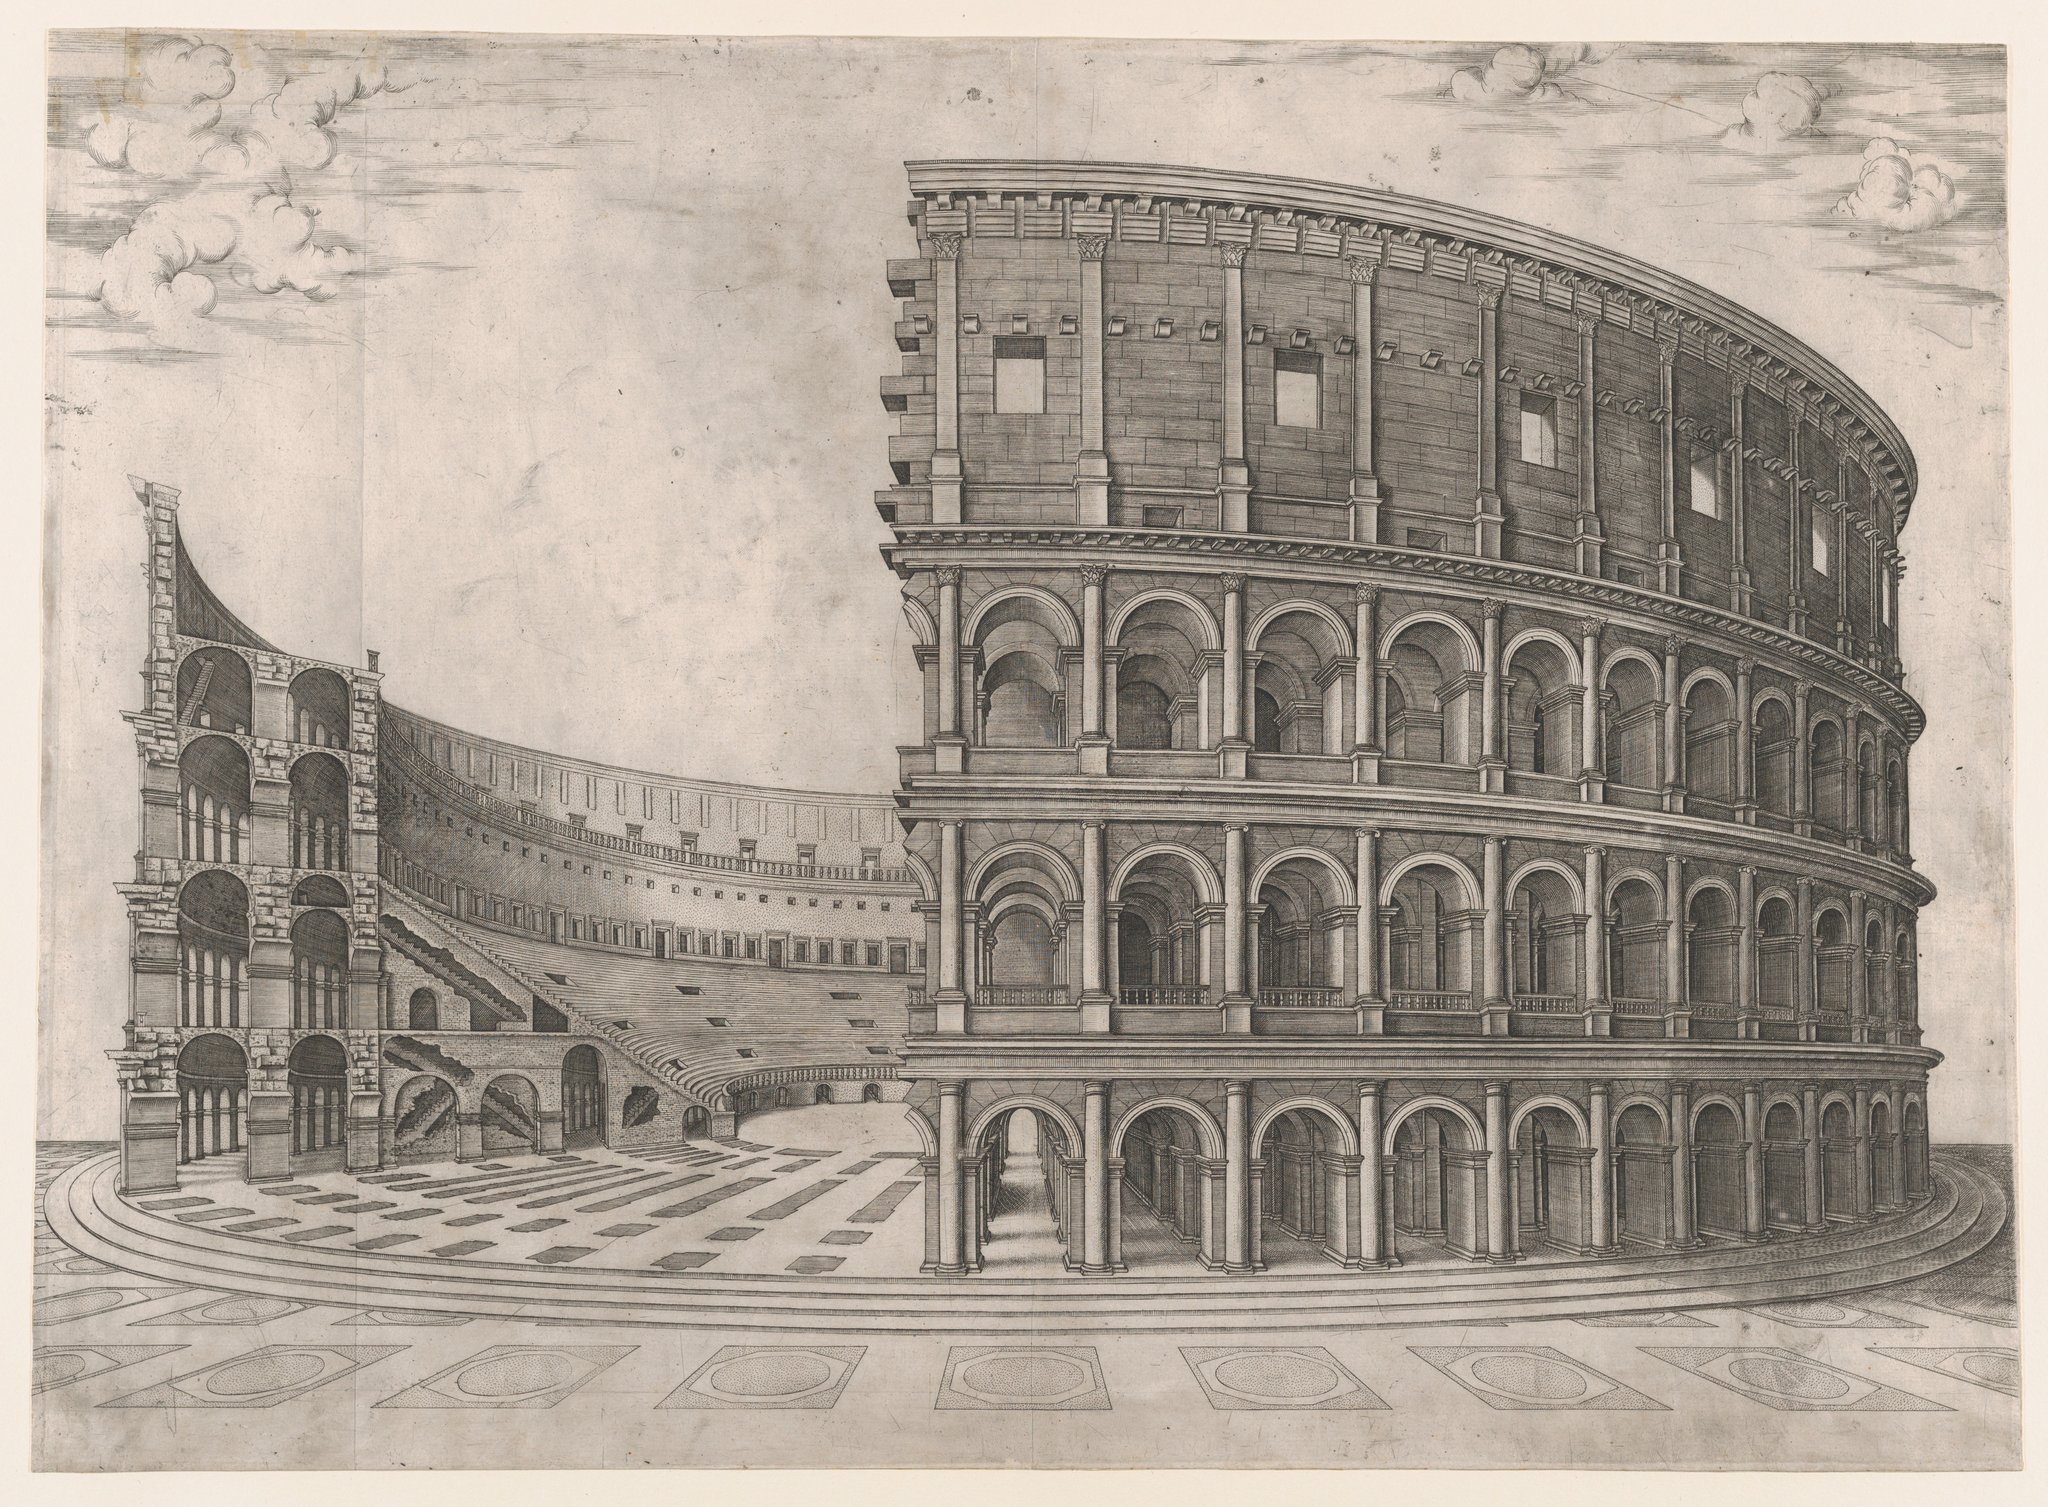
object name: print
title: Interior and Exterior of the Colosseum, from "Speculum Romanae Magnificentiae"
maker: Anonymous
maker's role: artist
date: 1501-1600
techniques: engraving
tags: architecture,rome